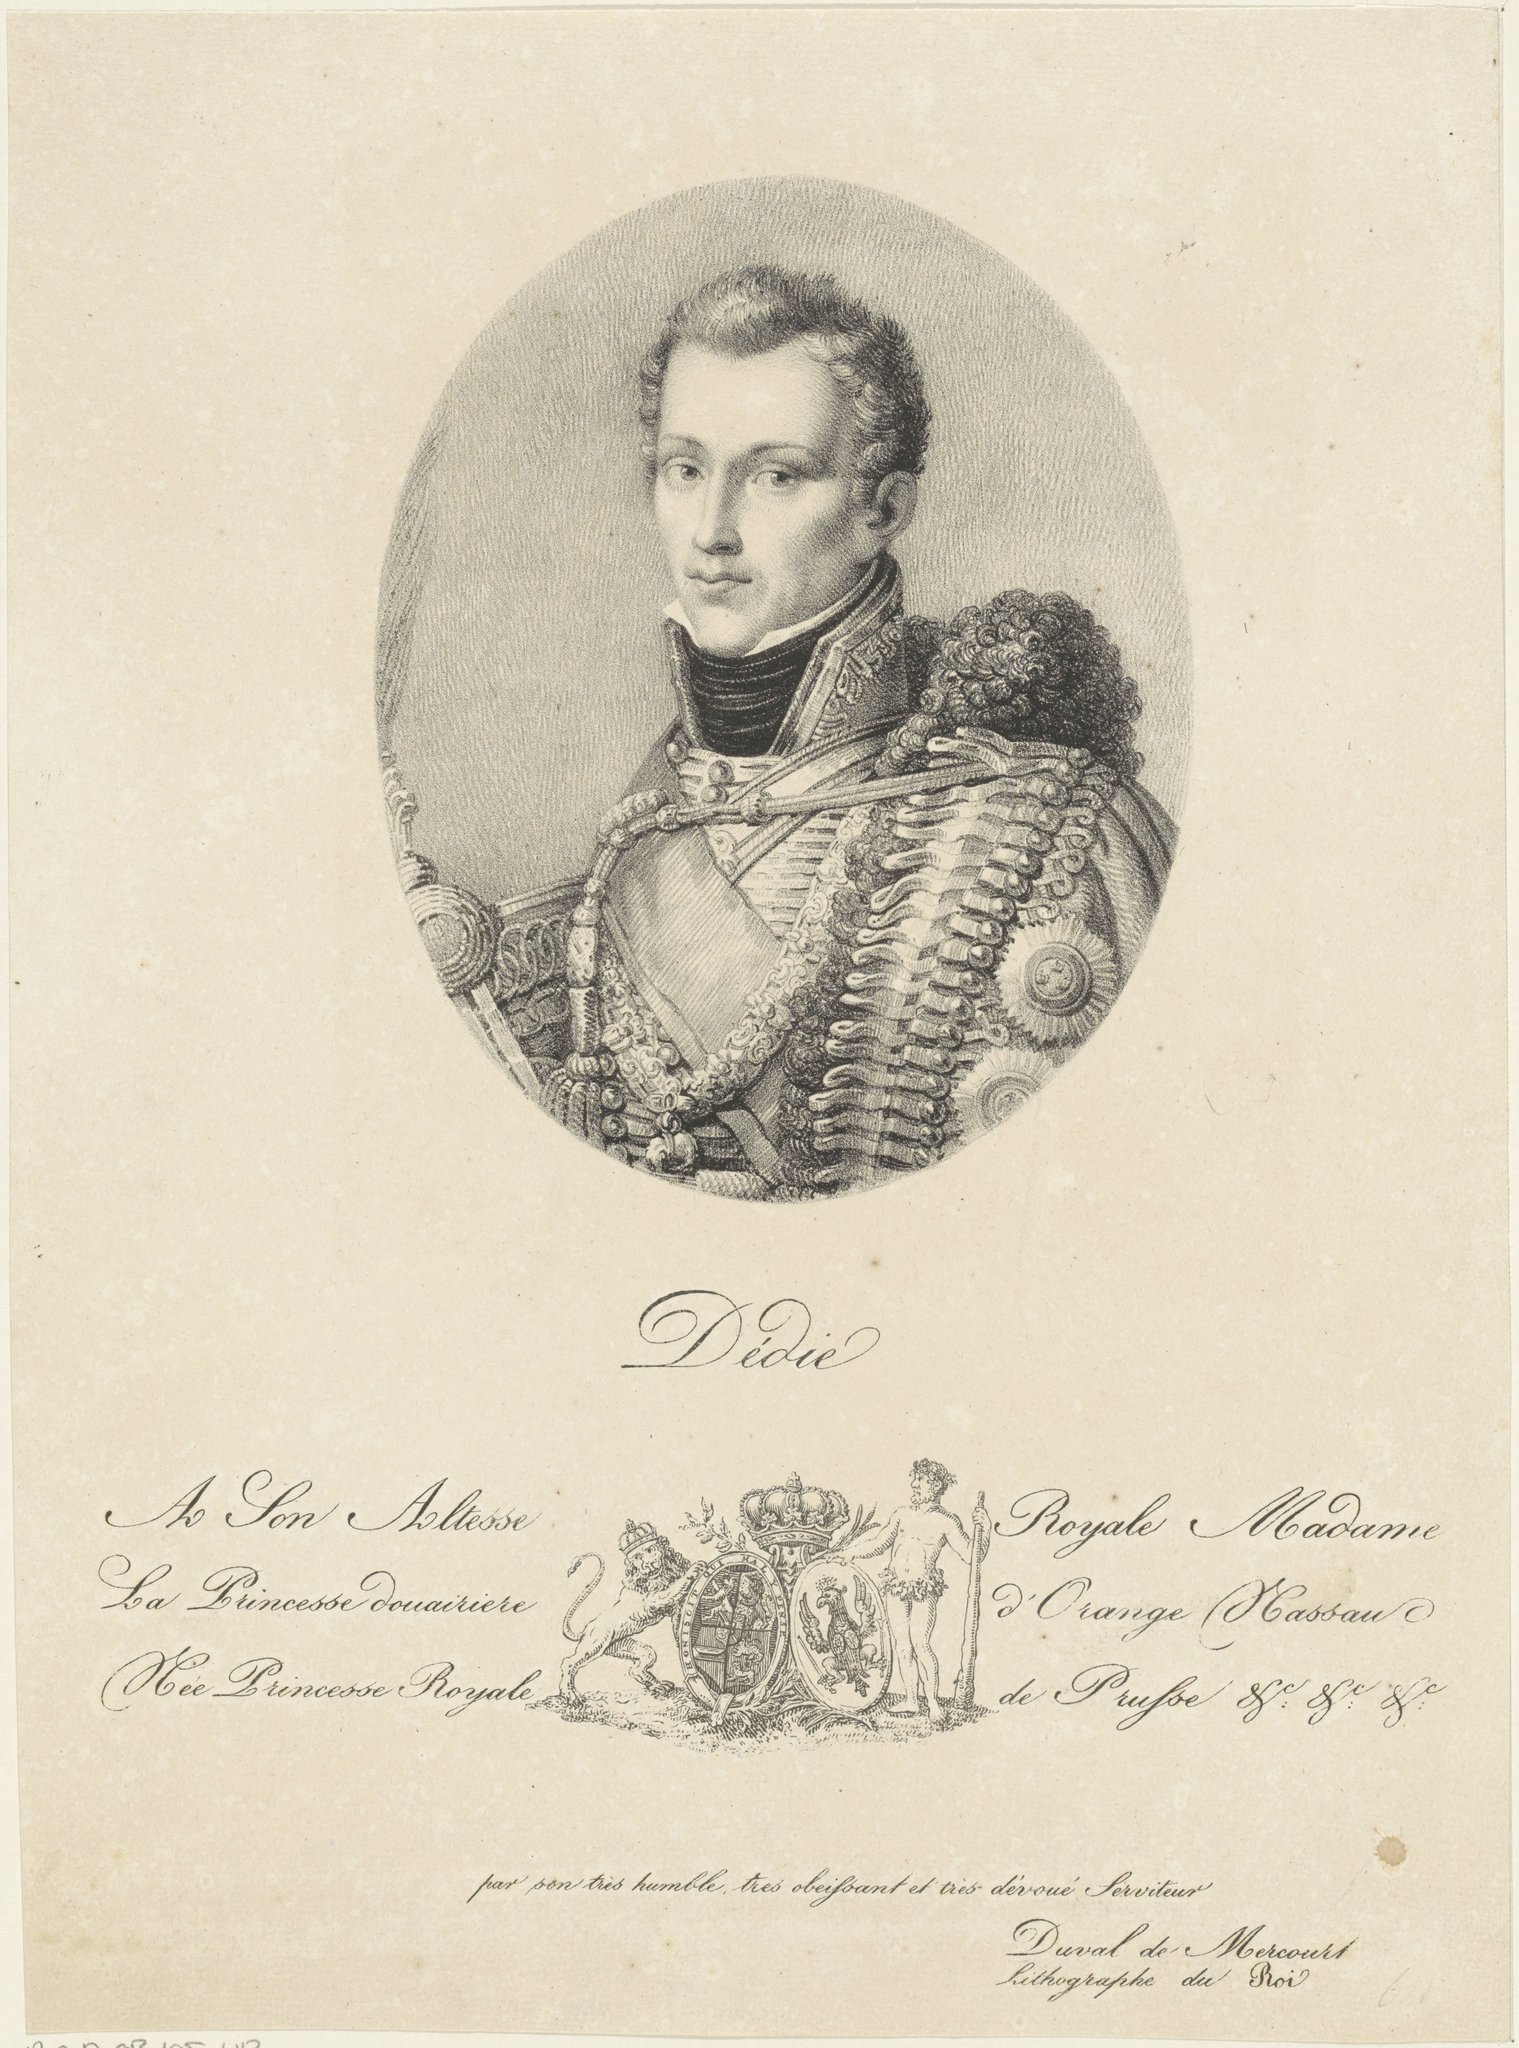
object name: print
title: Portret van Willem II, koning der Nederlanden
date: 1818-1819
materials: paper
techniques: lithograph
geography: the hague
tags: william ii of the netherlands, painter, draughtsman, wilhelmina of prussia (princess of orange), knighthood order (garter) - insignia of a knighthood order, e.g.: badge, chain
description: Portret van Willem II in een ovaal. Midden onder zijn wapen, gedecoreerd met de Kousenband en het devies van de Orde van de Kousenband, en het wapen van Wilhelmina met een kroon, een leeuw en Hercules. In de ondermarge vijf regels Franse tekst.